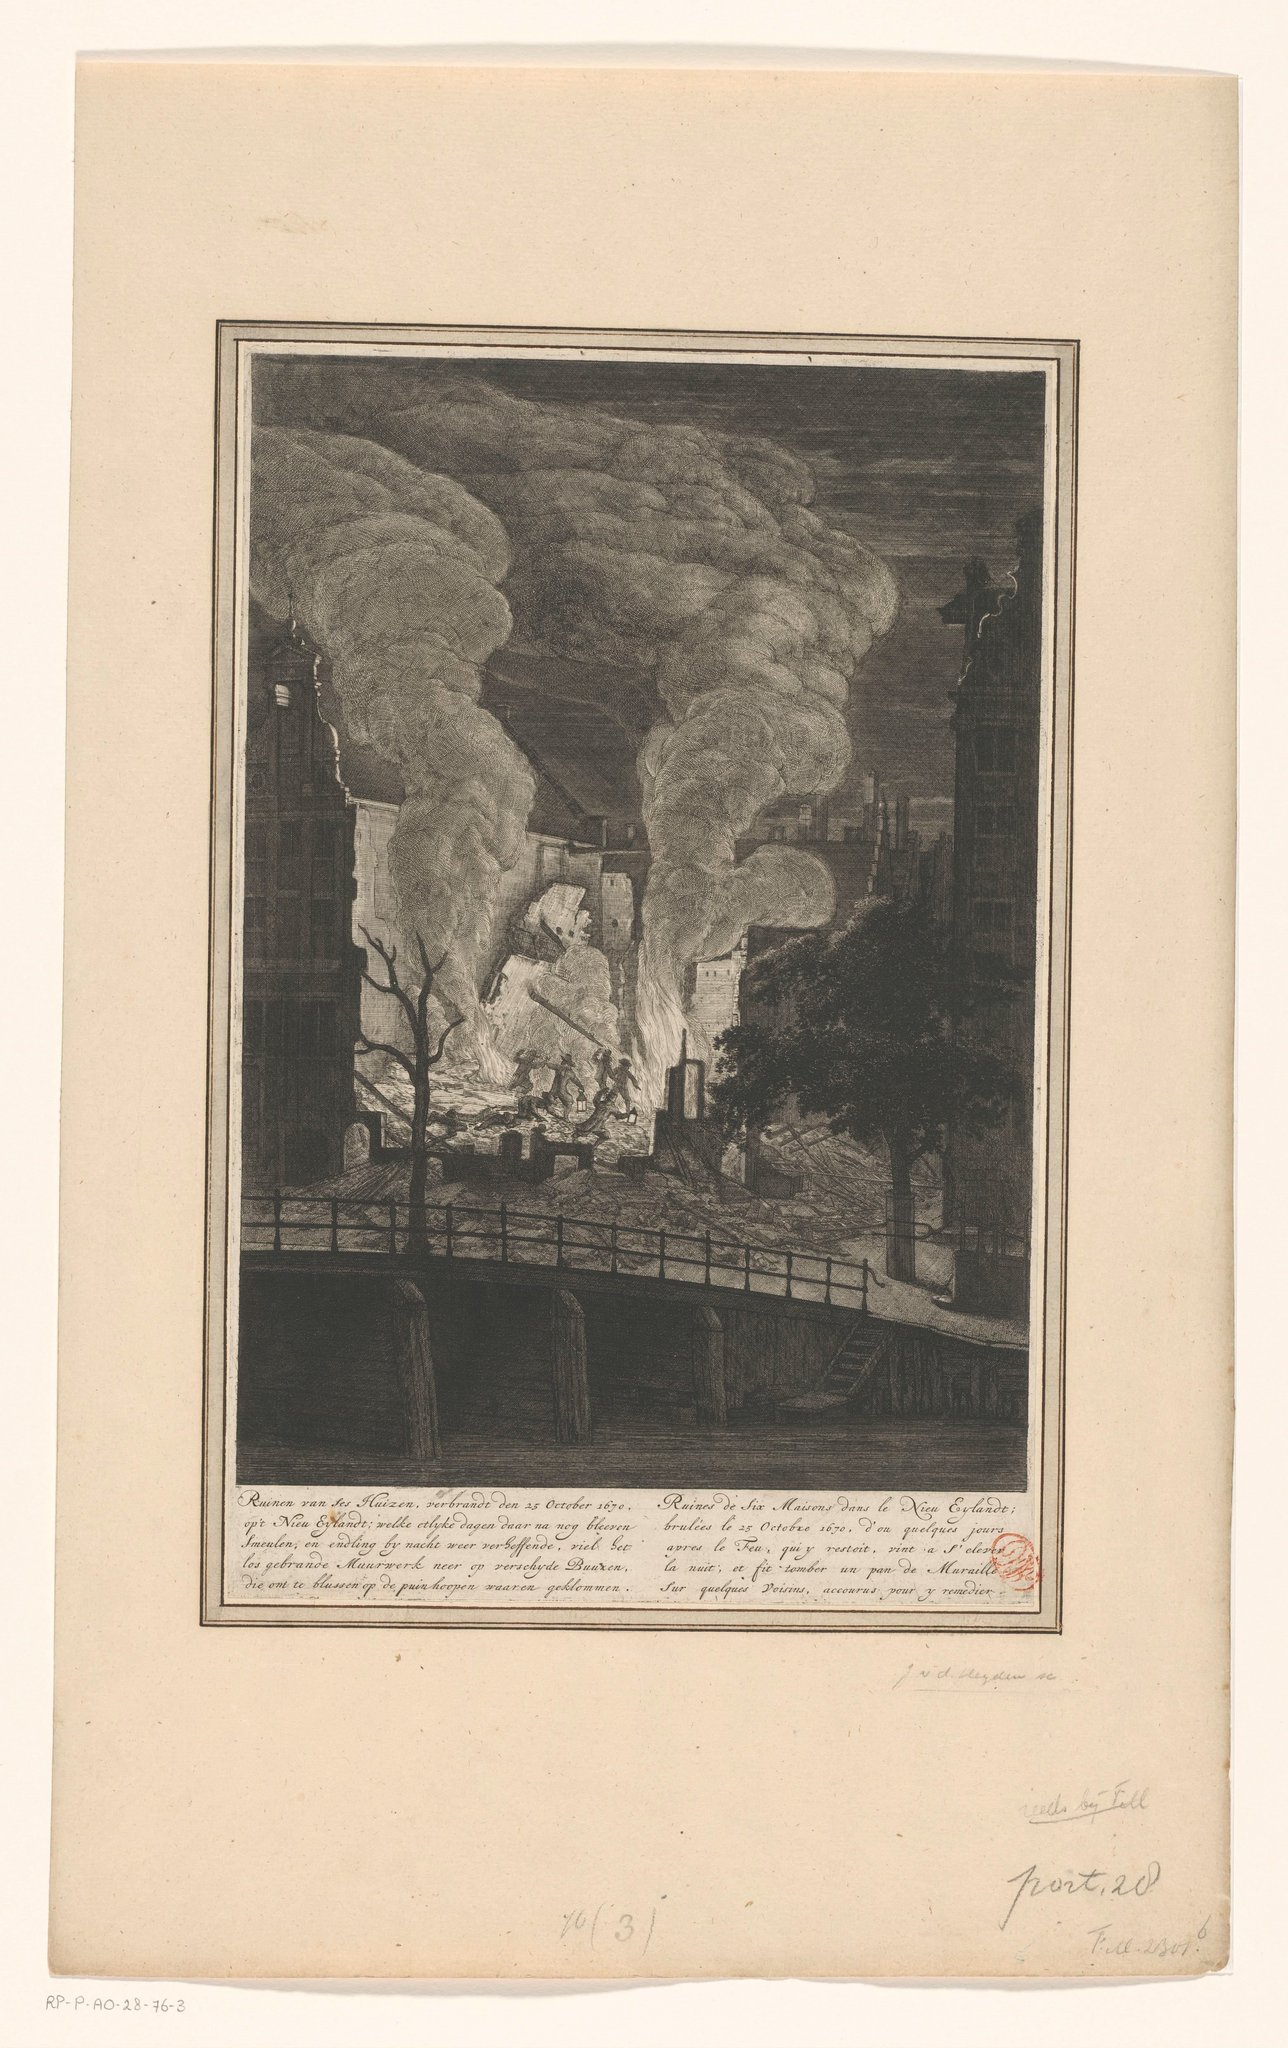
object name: book illustration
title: Brand op het Waalseiland te Amsterdam, 1670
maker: jan van der heyden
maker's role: draughtsman, painter, print maker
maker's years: 1637-1712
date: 1690-1735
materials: paper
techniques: engraving, etching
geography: amsterdam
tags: amsterdam, painter, print maker, draughtsman, jan van der heyden, on fire, ablaze, fire-fighting, fire-extinguishing equipment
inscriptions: collector's mark: Lugt 195, collector's mark: Lugt 2228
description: Prent ook gebruikt in: Heyden, Jan van der. Beschryving der nieuwlyks uitgevonden en geoctrojeerde slang-brand-spuiten en haare wyze van brand-blussen, tegenwoordig binnen Amsterdam in gebruik zijnde (…). 1e druk. Amsterdam: Jan Rieuwertsz. (II), 1690. En in: Heyden, Jan van der. Beschryving der nieuwlyks uitgevonden en geoctrojeerde slang-brand-spuiten en haare wyze van brand-blussen, tegenwoordig binnen Amsterdam in gebruik zijnde (…). 2e druk. Amsterdam: erfgenamen Jan van der Heyden, 1735.